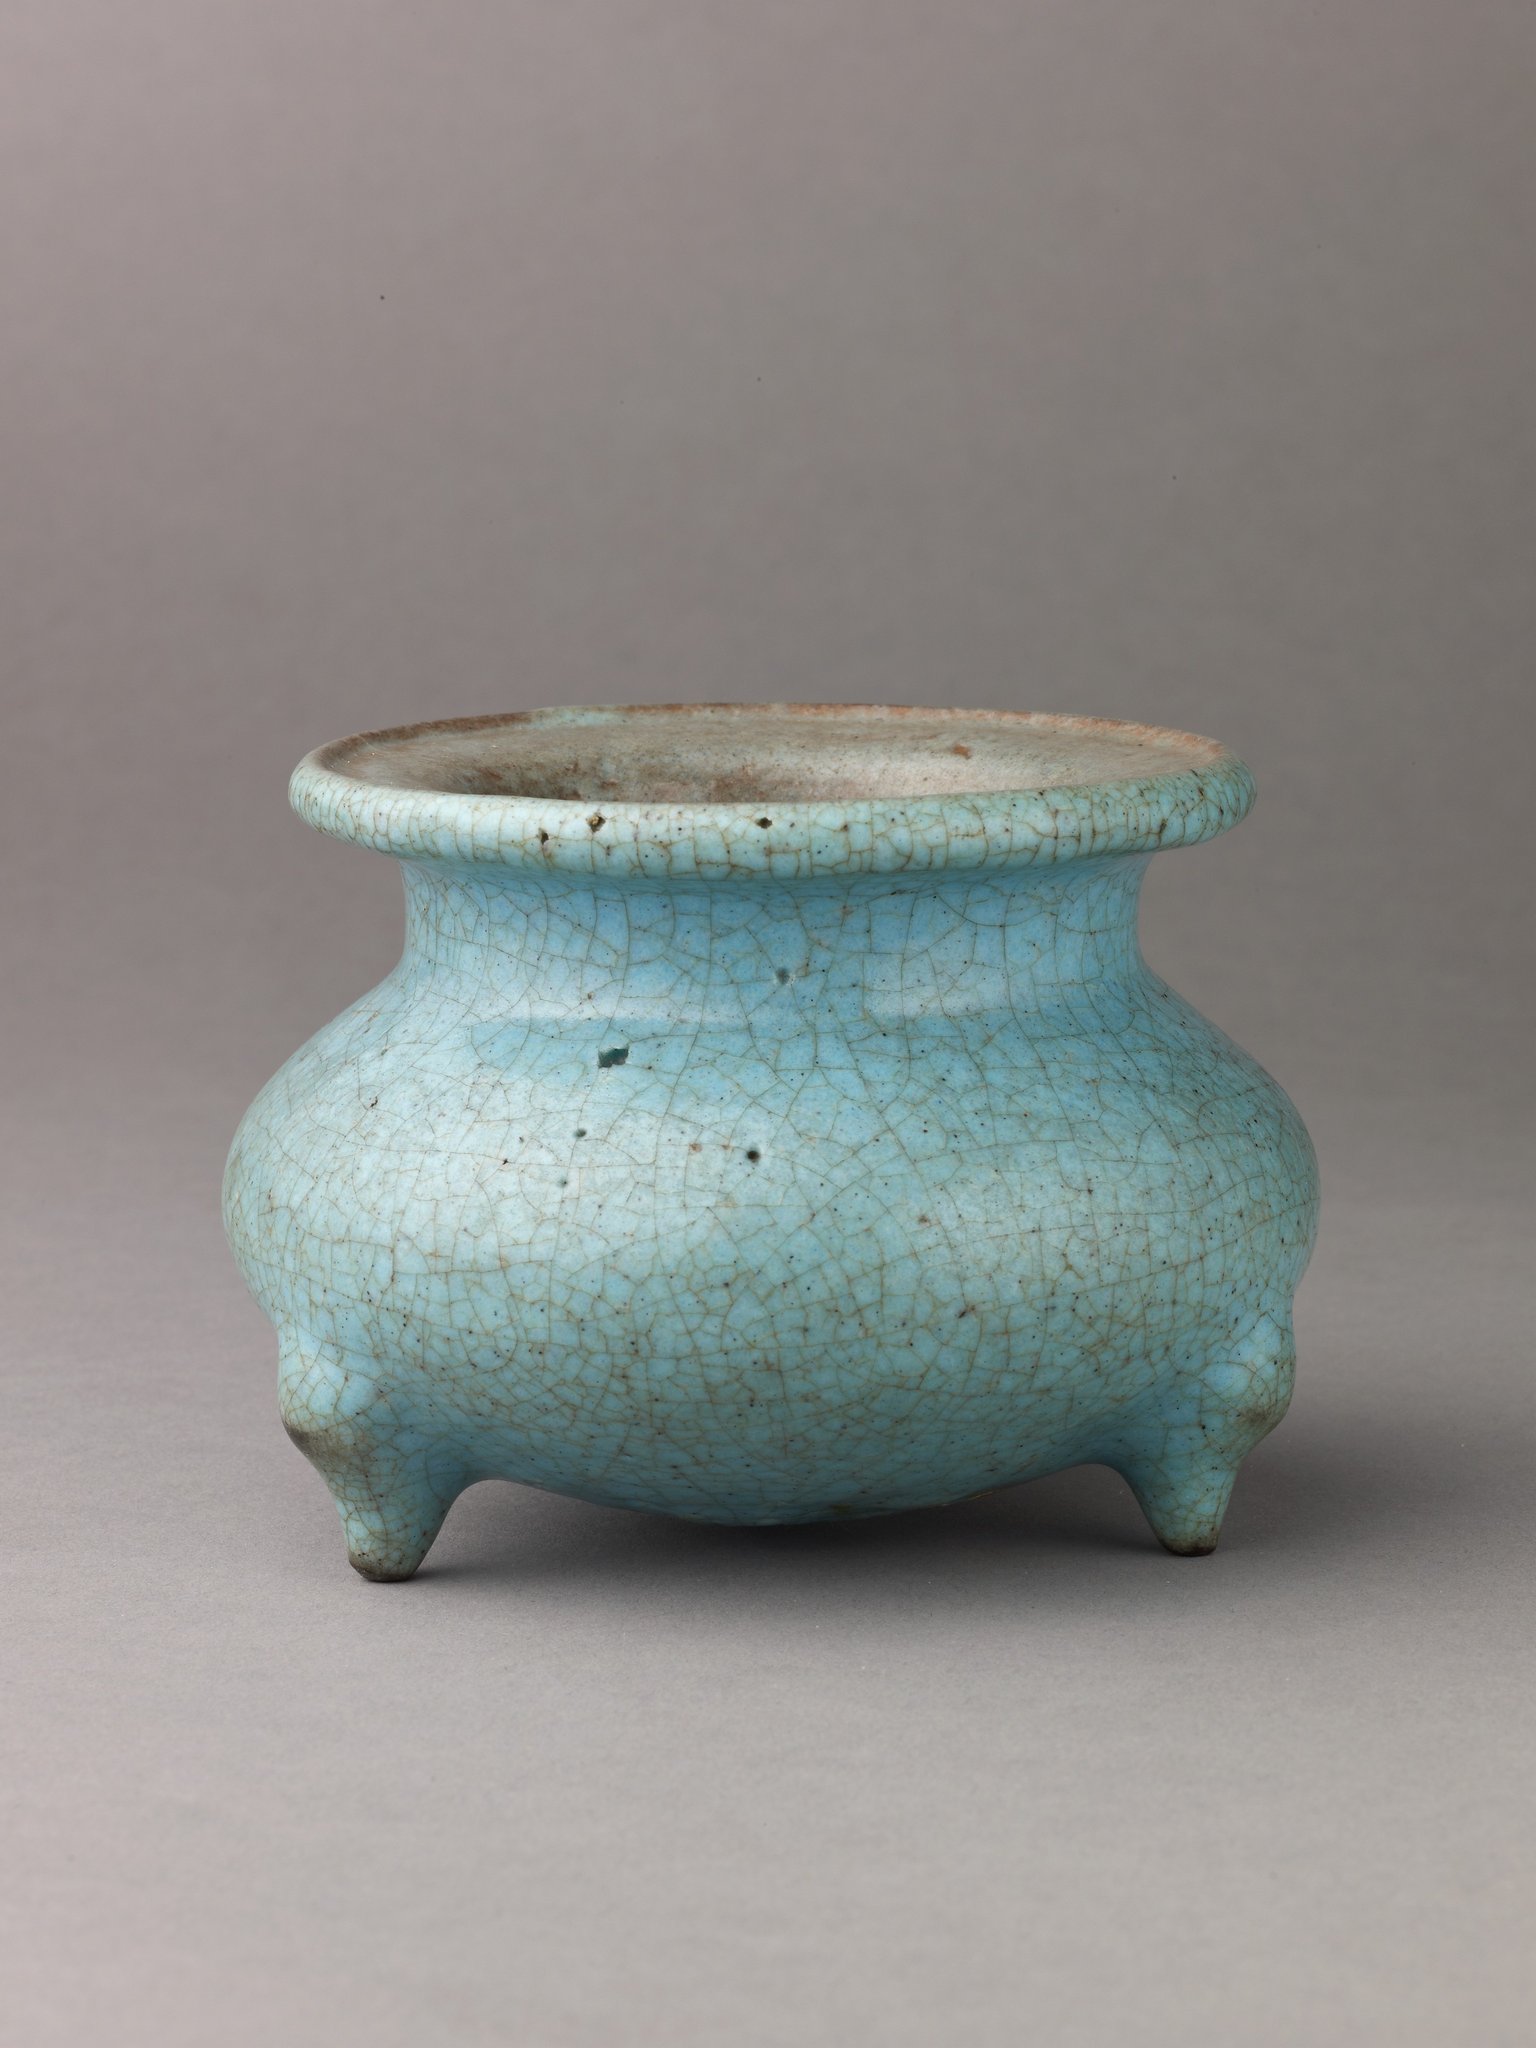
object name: incense burner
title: Small incense burner, 'Ma Jun' or 'Soft Jun' ware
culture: chinese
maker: chinese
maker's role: artist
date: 1201-1400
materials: glaze, stoneware